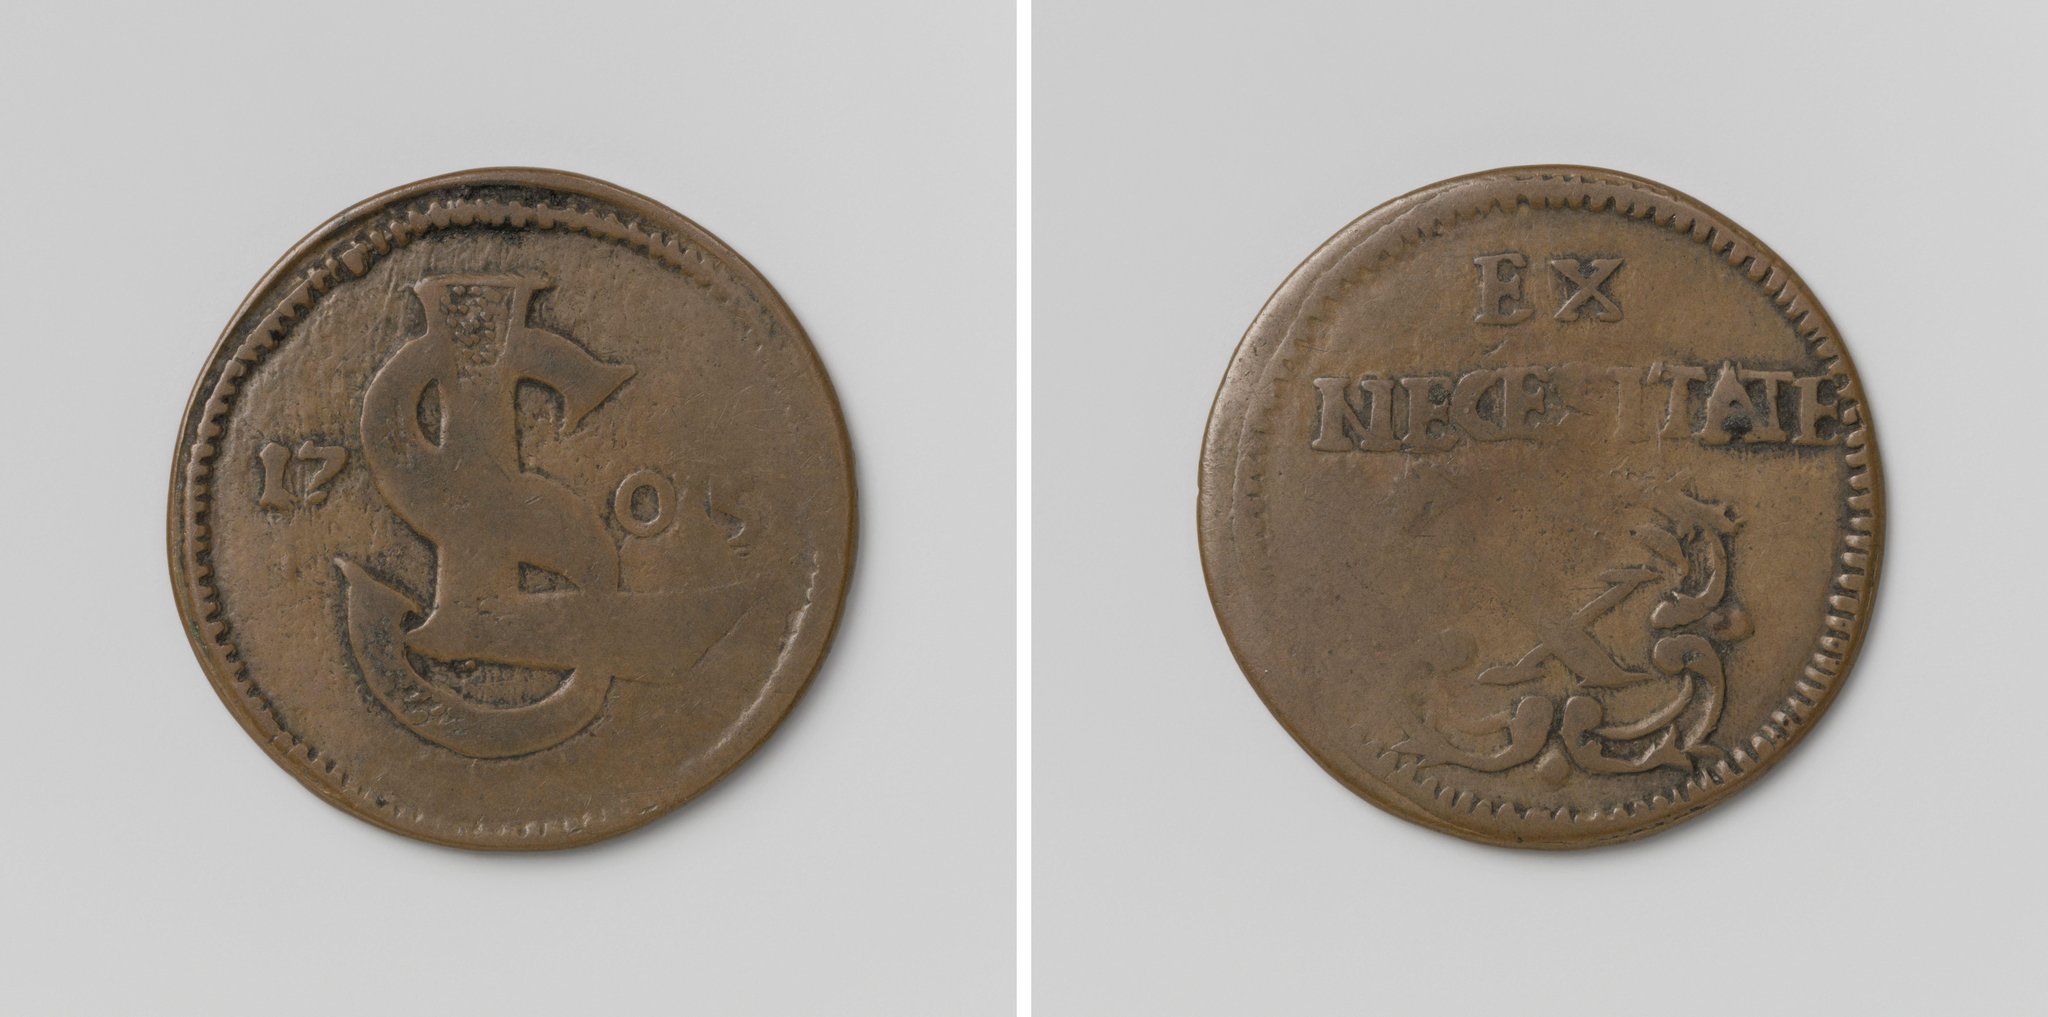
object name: siege coin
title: Tien poltura, noodmunt uit Leopoldstadt, geslagen door de ontevredenen in Hongarije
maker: Anonymous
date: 1705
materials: copper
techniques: striking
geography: leopoldstadt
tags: vorst, frans ragotzky, hongarije, rákóczi's opstand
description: Voorzijde: monogram van letters S en L tussen jaartal. Keerzijde: opschrift boven Romeins cijfer X in versierd cartouche